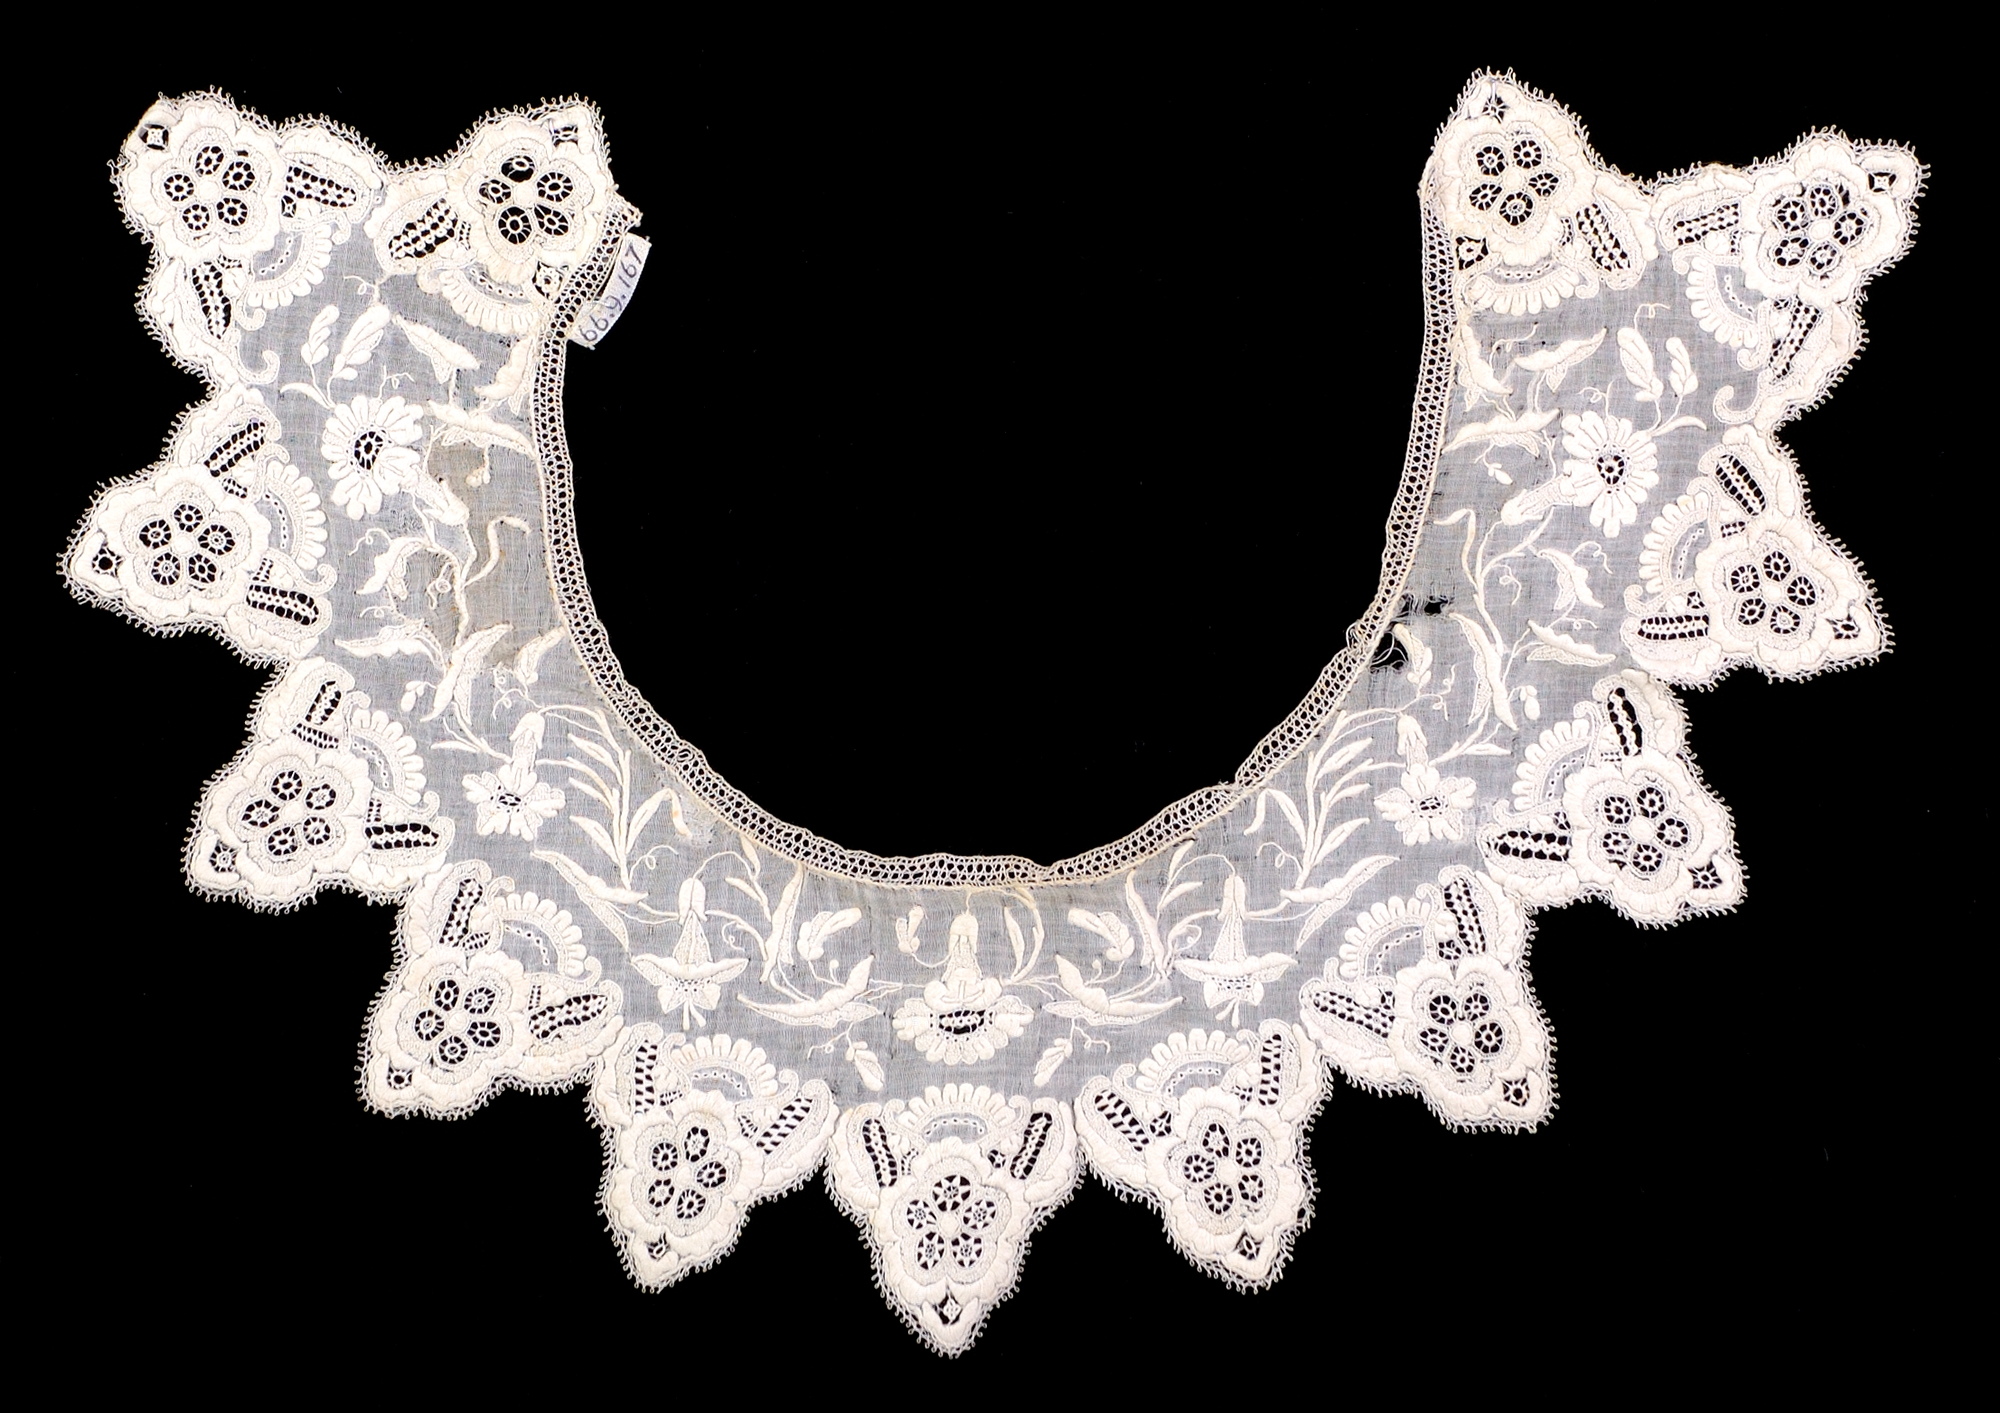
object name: collar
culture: swiss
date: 1840-1860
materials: cotton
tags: flowers